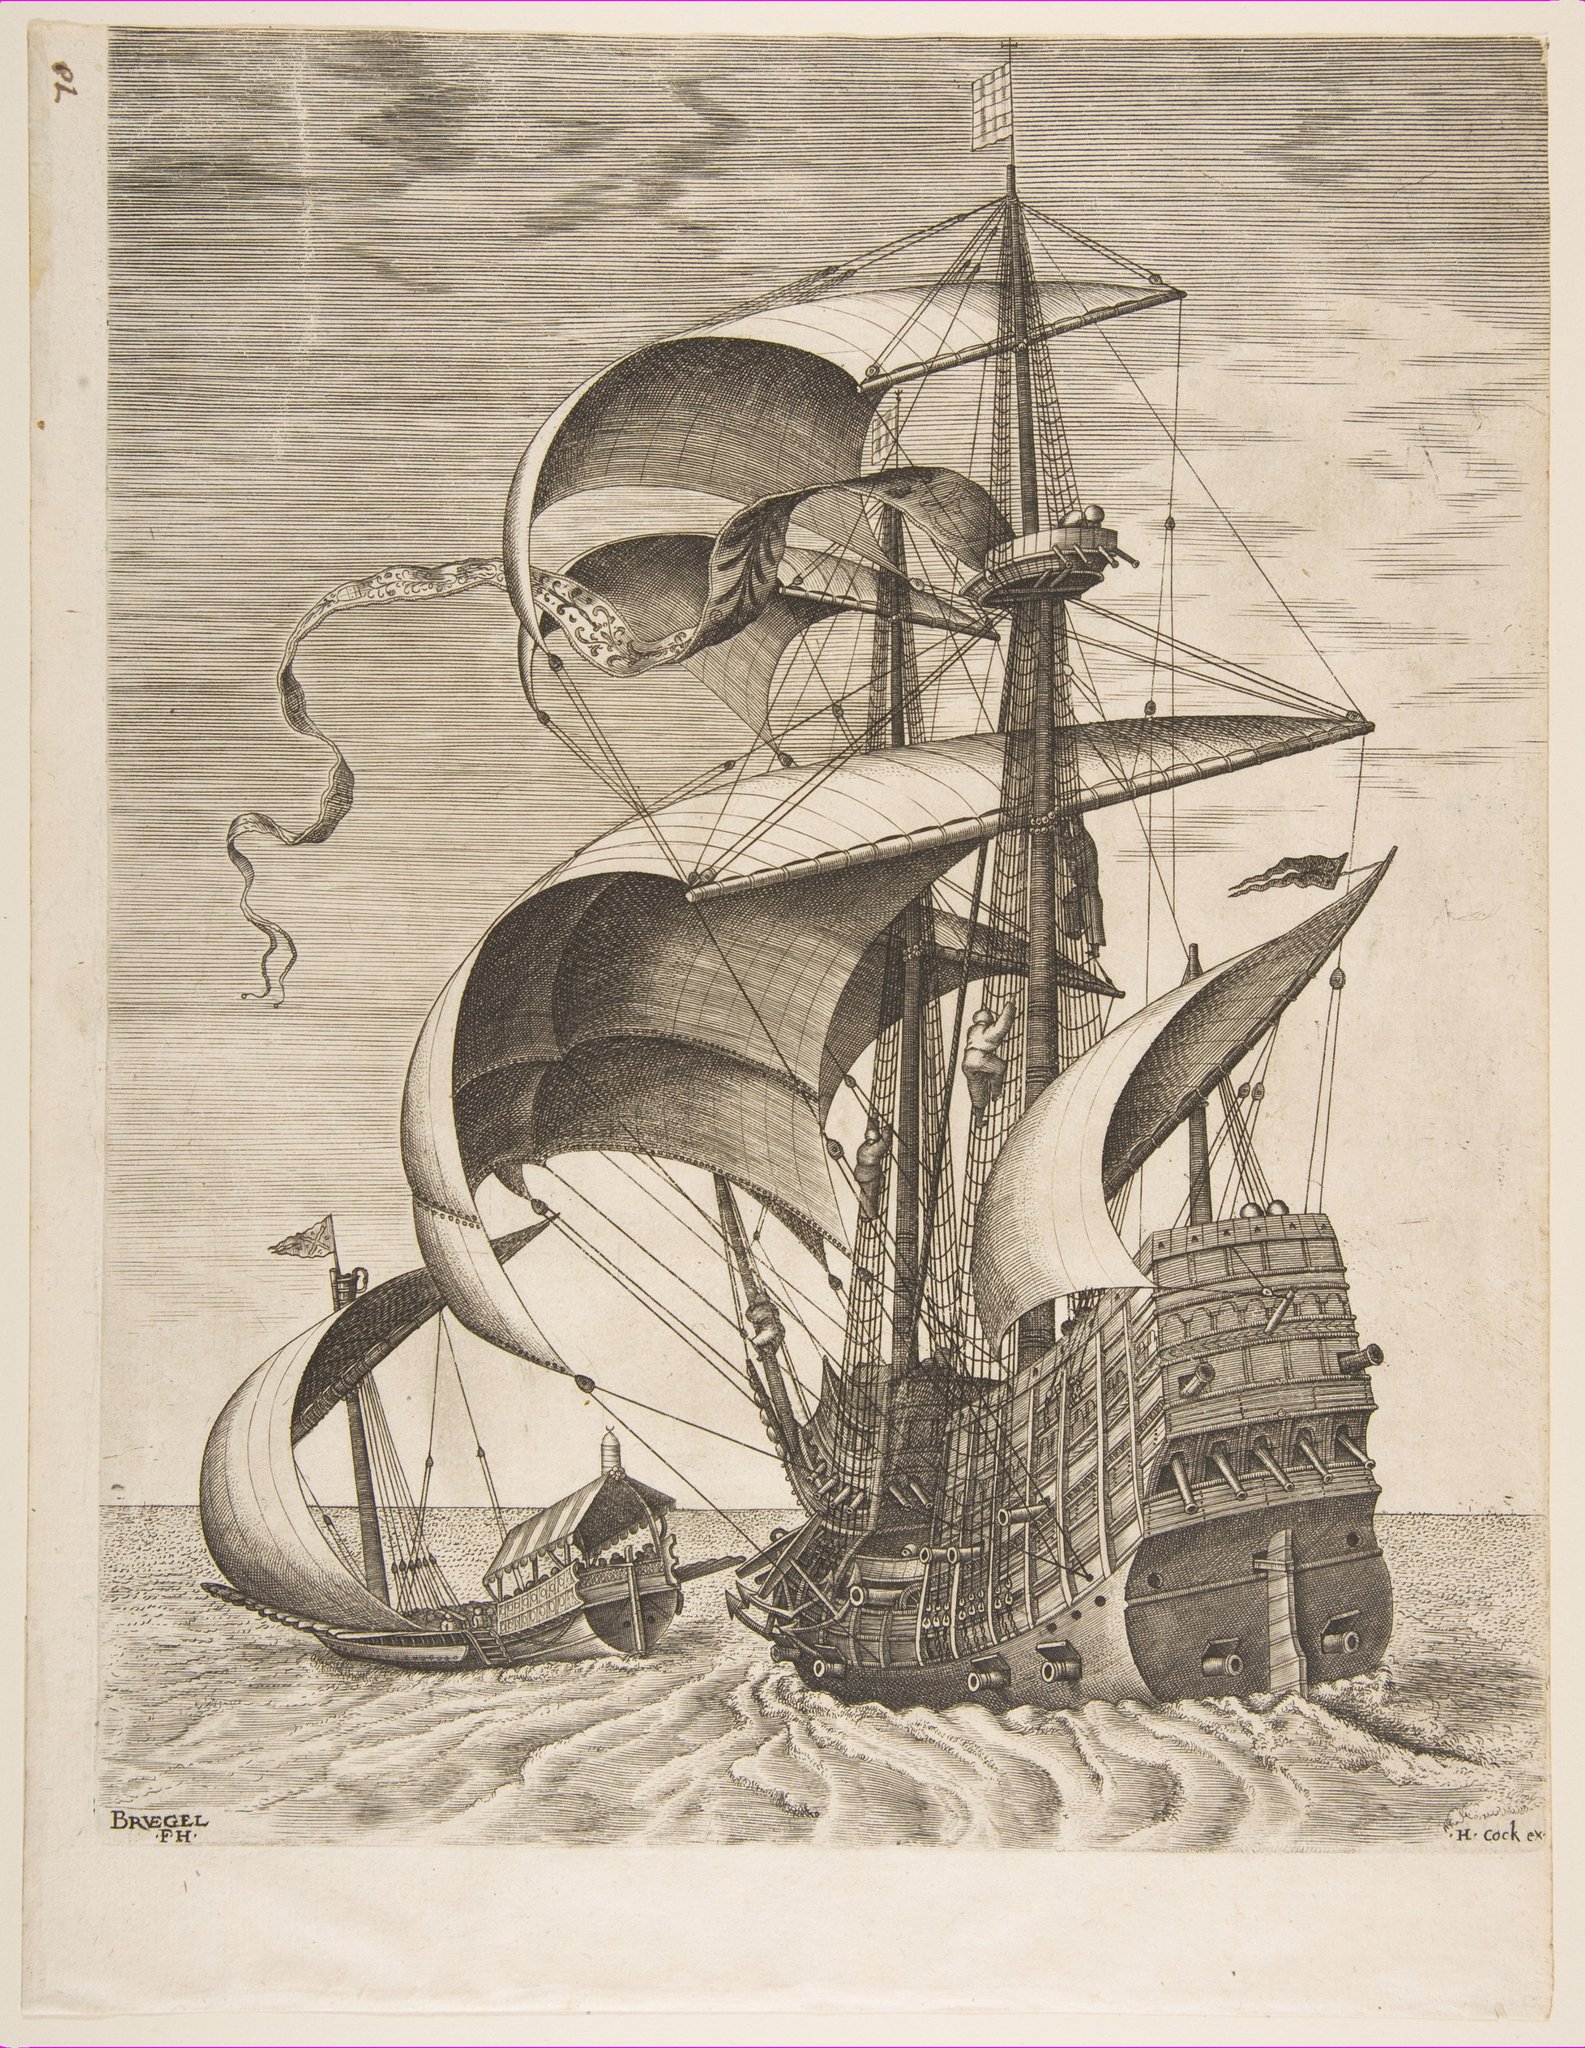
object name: print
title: Armed Three-Master on the Open Sea Accompanied by a Galley from The Sailing Vessels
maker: pieter bruegel the elder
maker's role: artist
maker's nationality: netherlandish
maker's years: 1525-1569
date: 1561-1565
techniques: engraving, etching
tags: ships